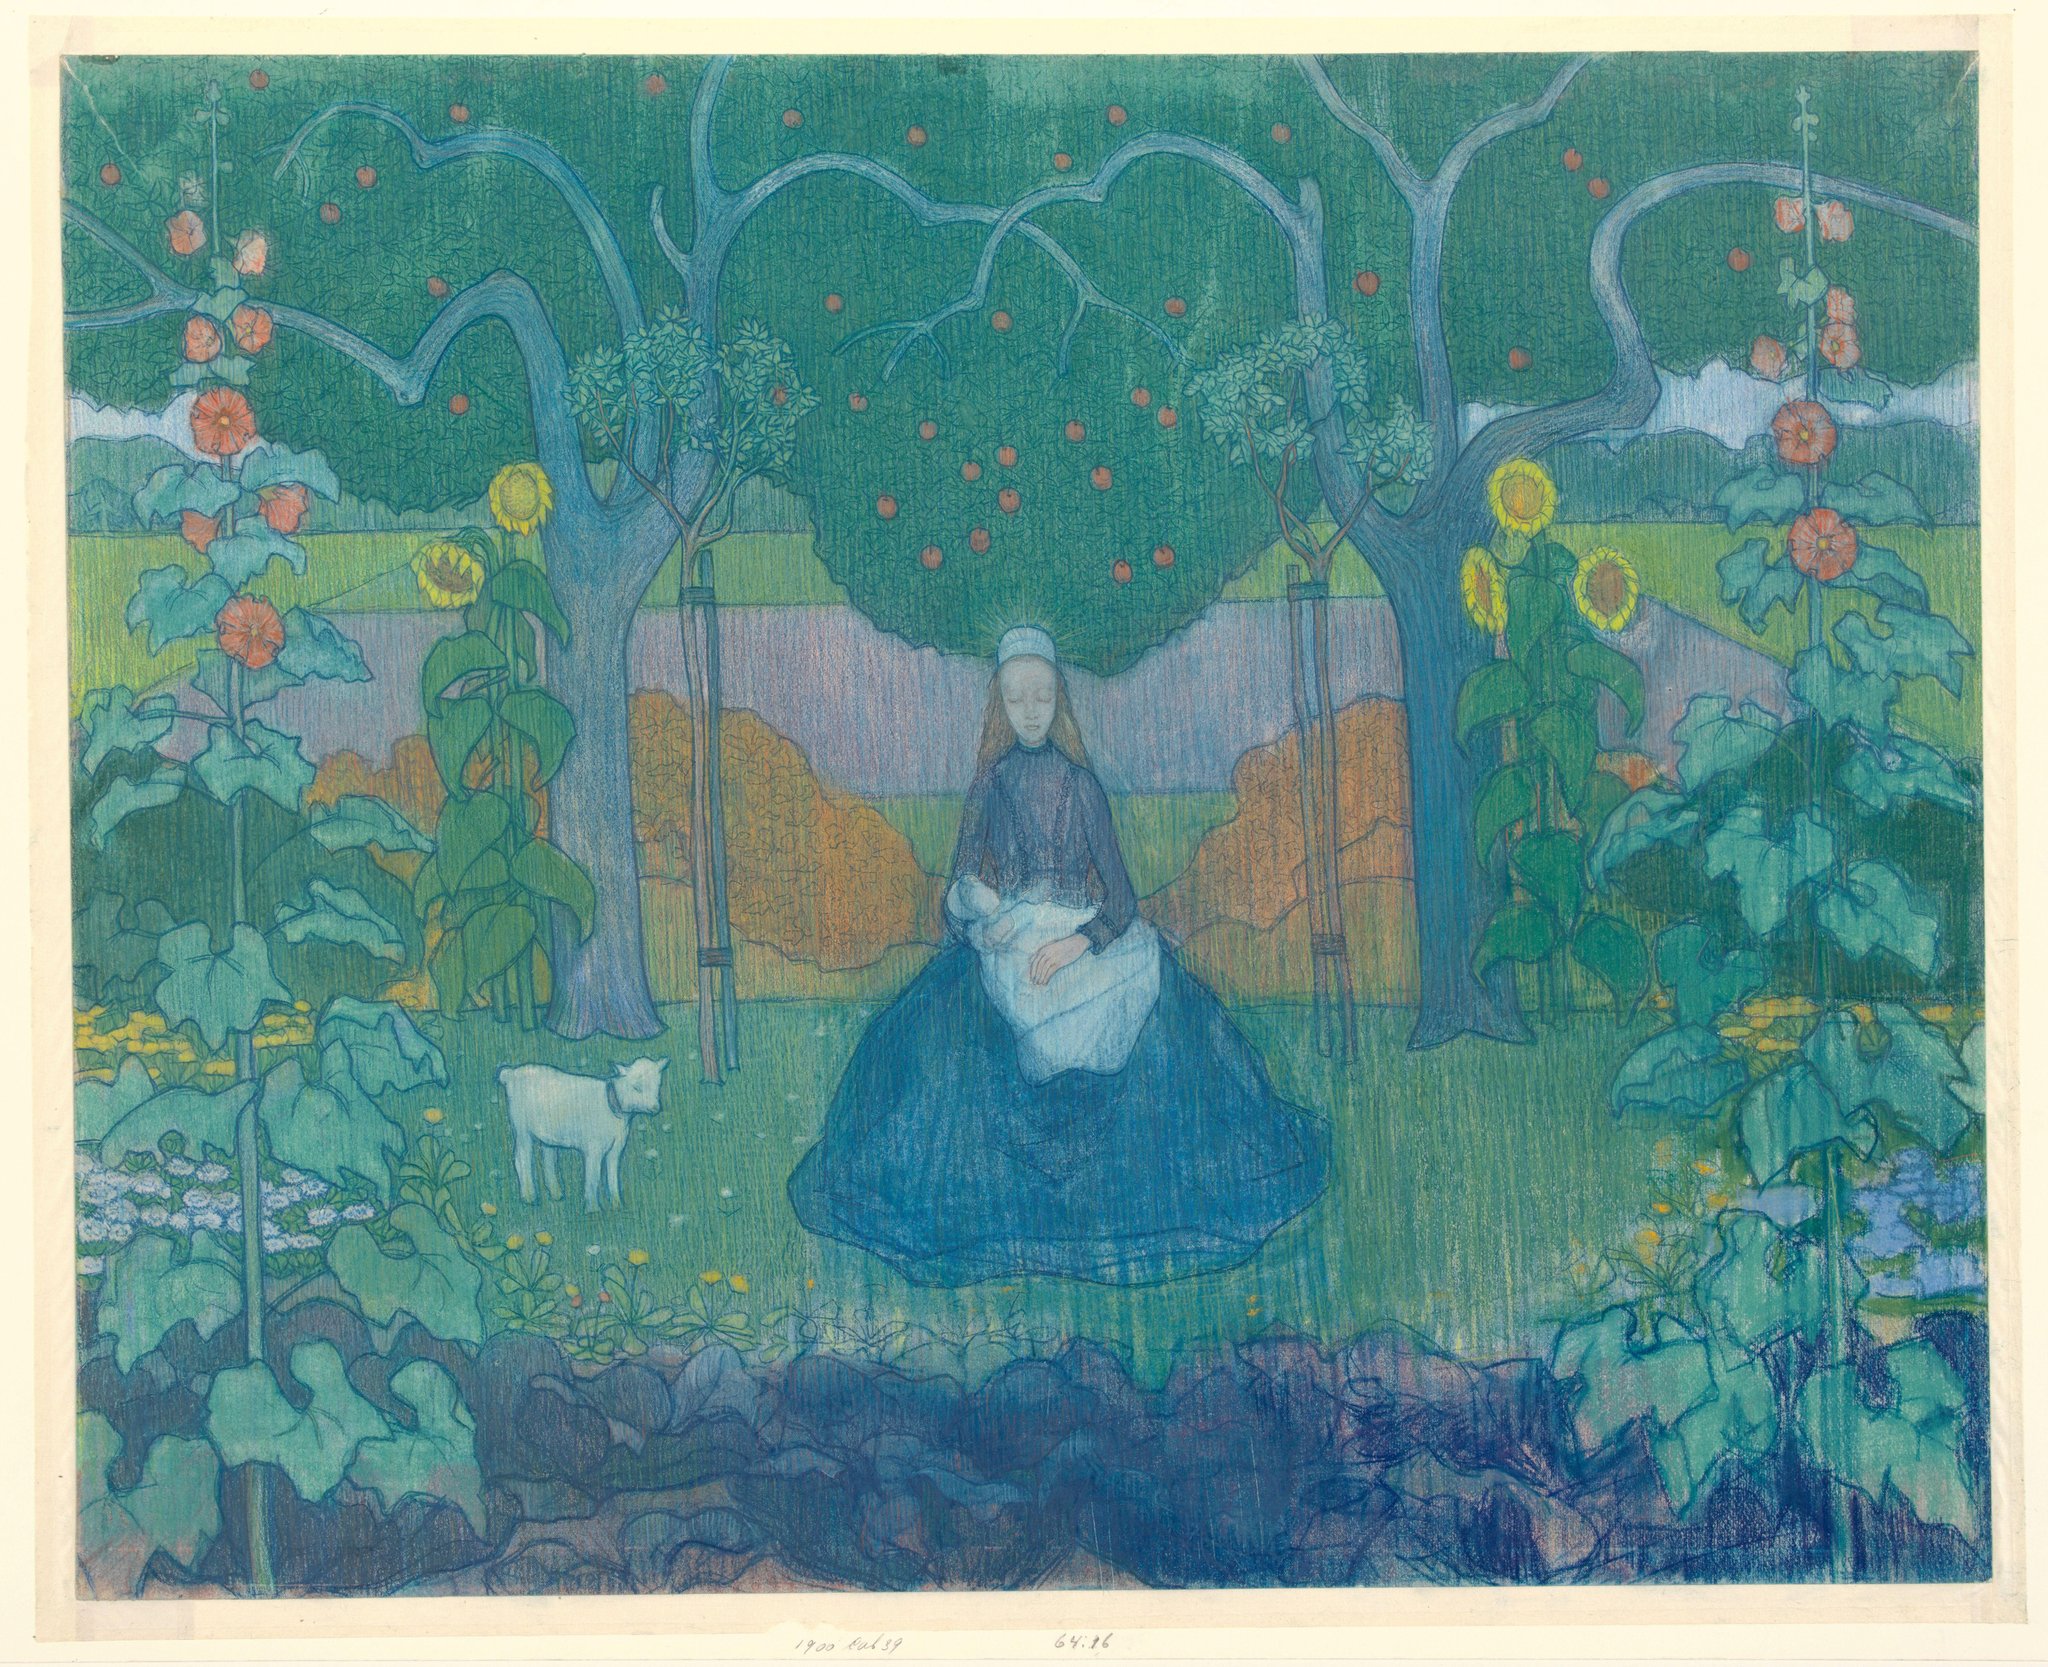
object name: drawing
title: Madonna met kind in een tuin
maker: edzard koning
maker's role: draughtsman, print maker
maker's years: 1869-1954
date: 1896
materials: chalk, paper, pastel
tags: madonna in the rose-garden, 'paradiesgärtlein', goat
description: Madonna met kind in een tuin, met zonnebloemen, stokrozen en appelbomen, links een klein geitje.